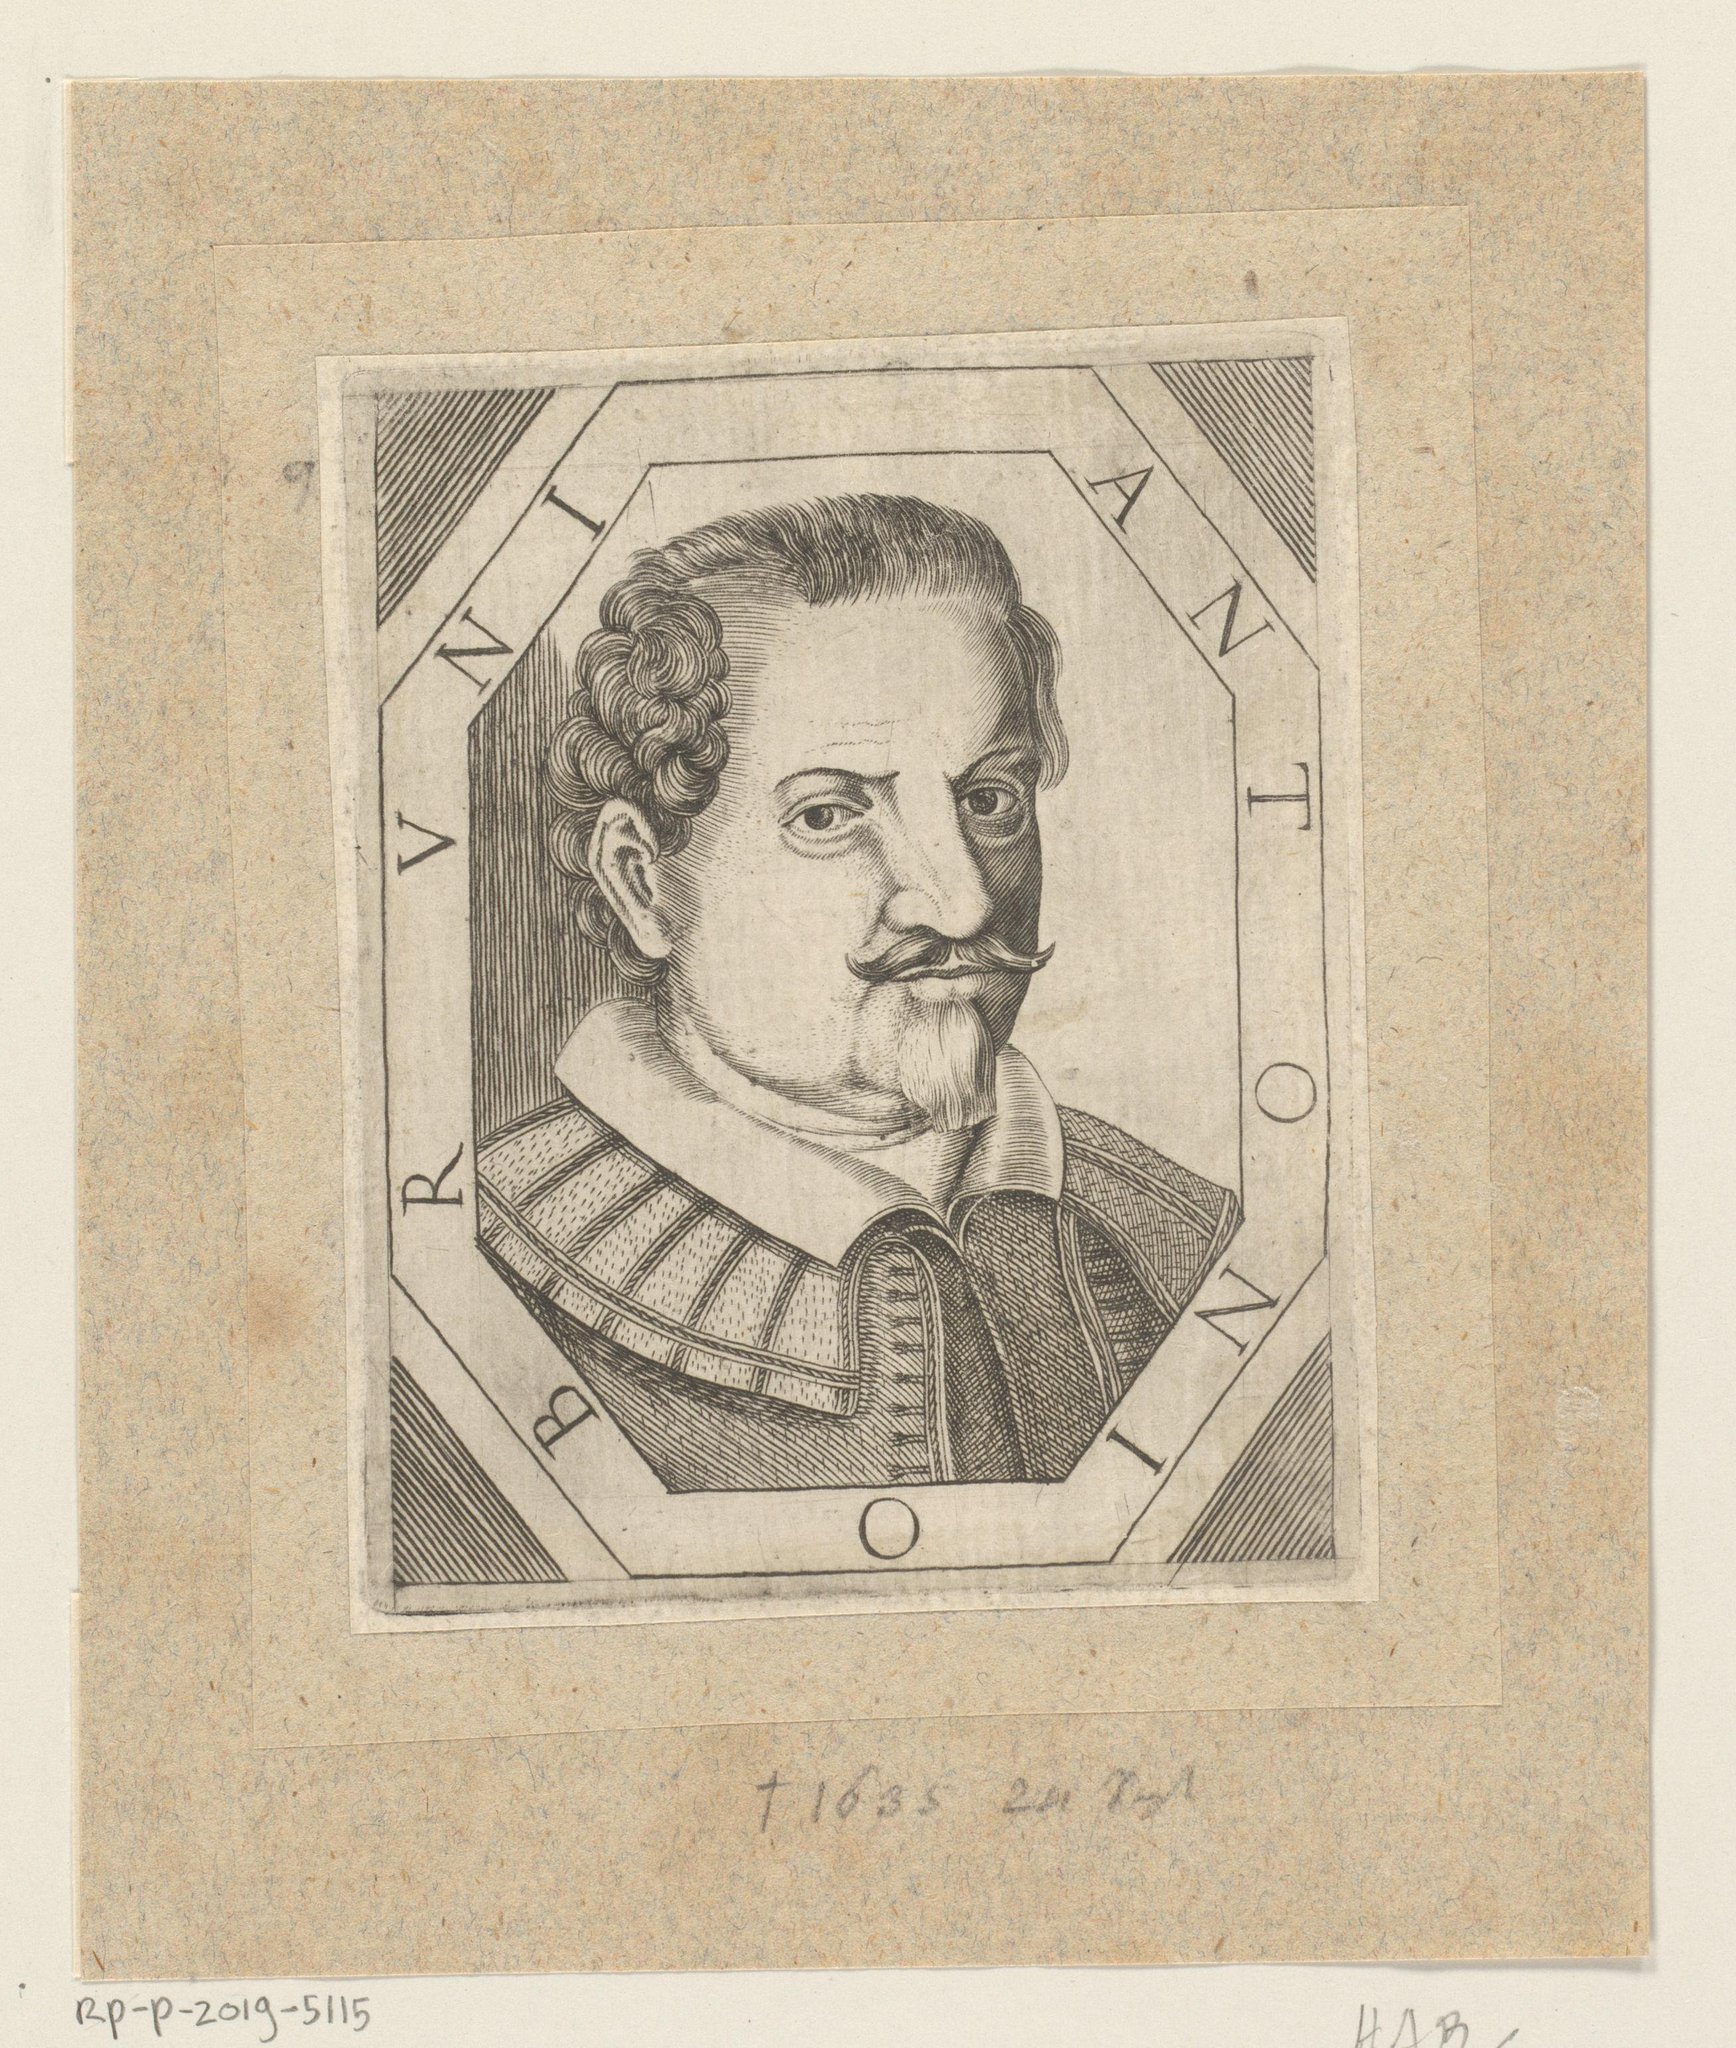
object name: book illustration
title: Antonio Bruni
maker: Anonymous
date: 1666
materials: paper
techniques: engraving, letterpress printing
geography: venice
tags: historical persons, portrait of a writer, writer, poet, author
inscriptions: inscription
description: Prent uit: Crasso, Lorenzo. Elogii degli huomini letterati scritti. Venetië: Combi & la Noù, 1666, dl. 2, p. 274.